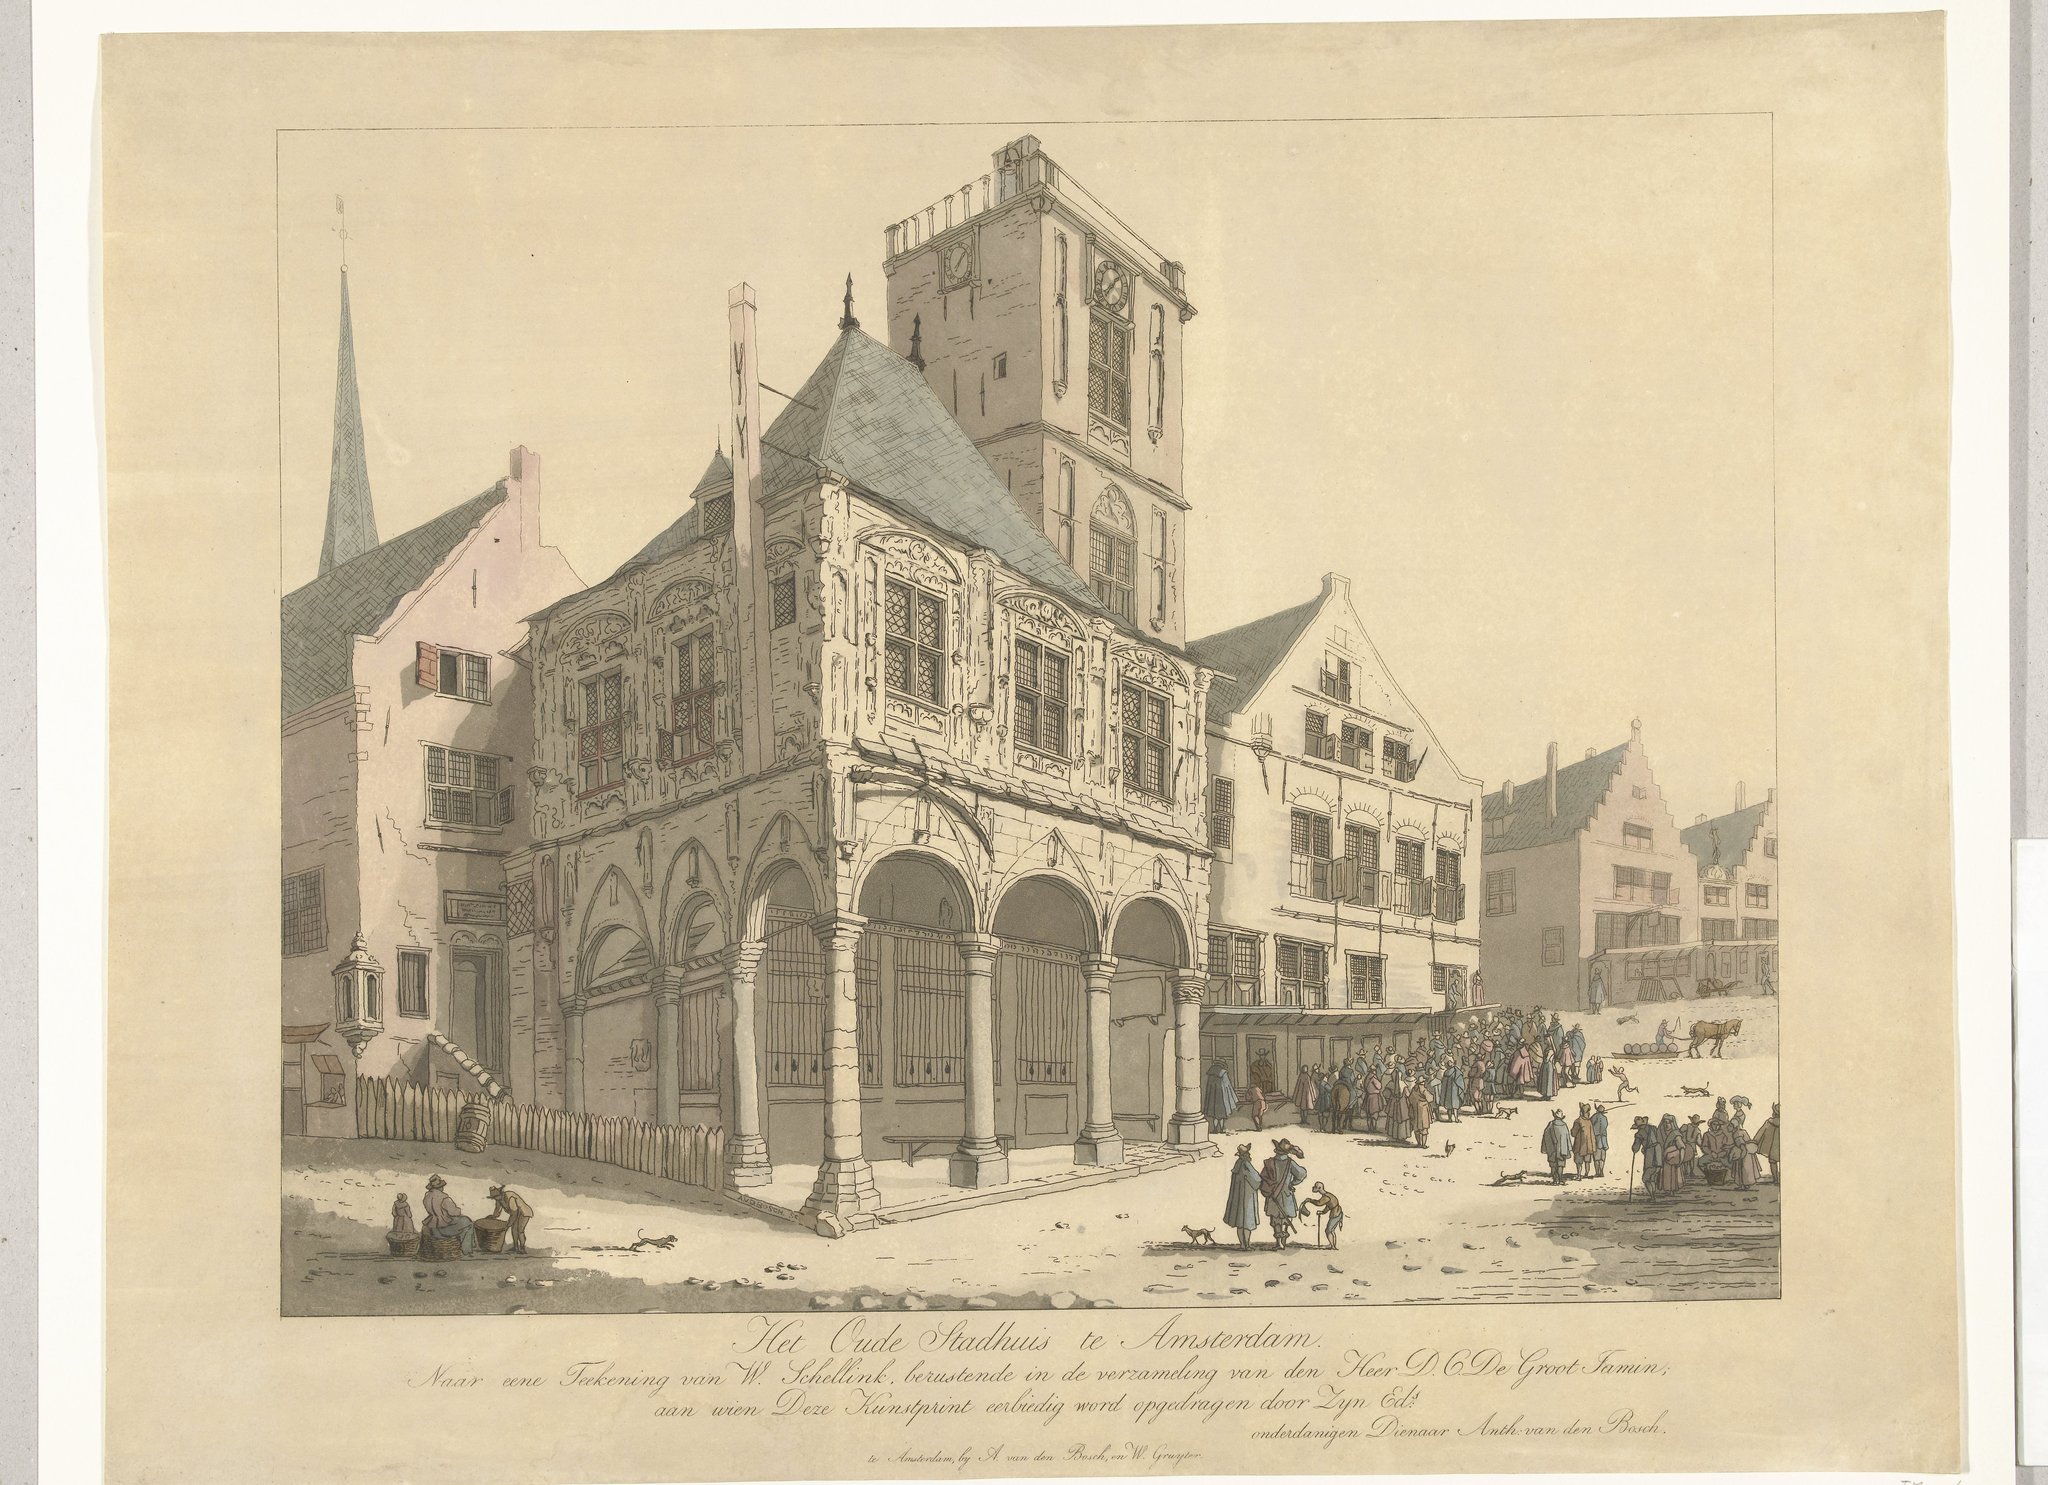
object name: print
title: Het Oude Stadhuis te Amsterdam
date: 1775-1838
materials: paper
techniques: print drawing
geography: amsterdam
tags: stadhuis van amsterdam (14e eeuw-1652)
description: Het Oude Stadhuis van Amsterdam, naar de tekening van 20 juni 1641. Op de stenen van de drempel een inscriptie over het afbranden van het stadhuis op 7 juli 1652.